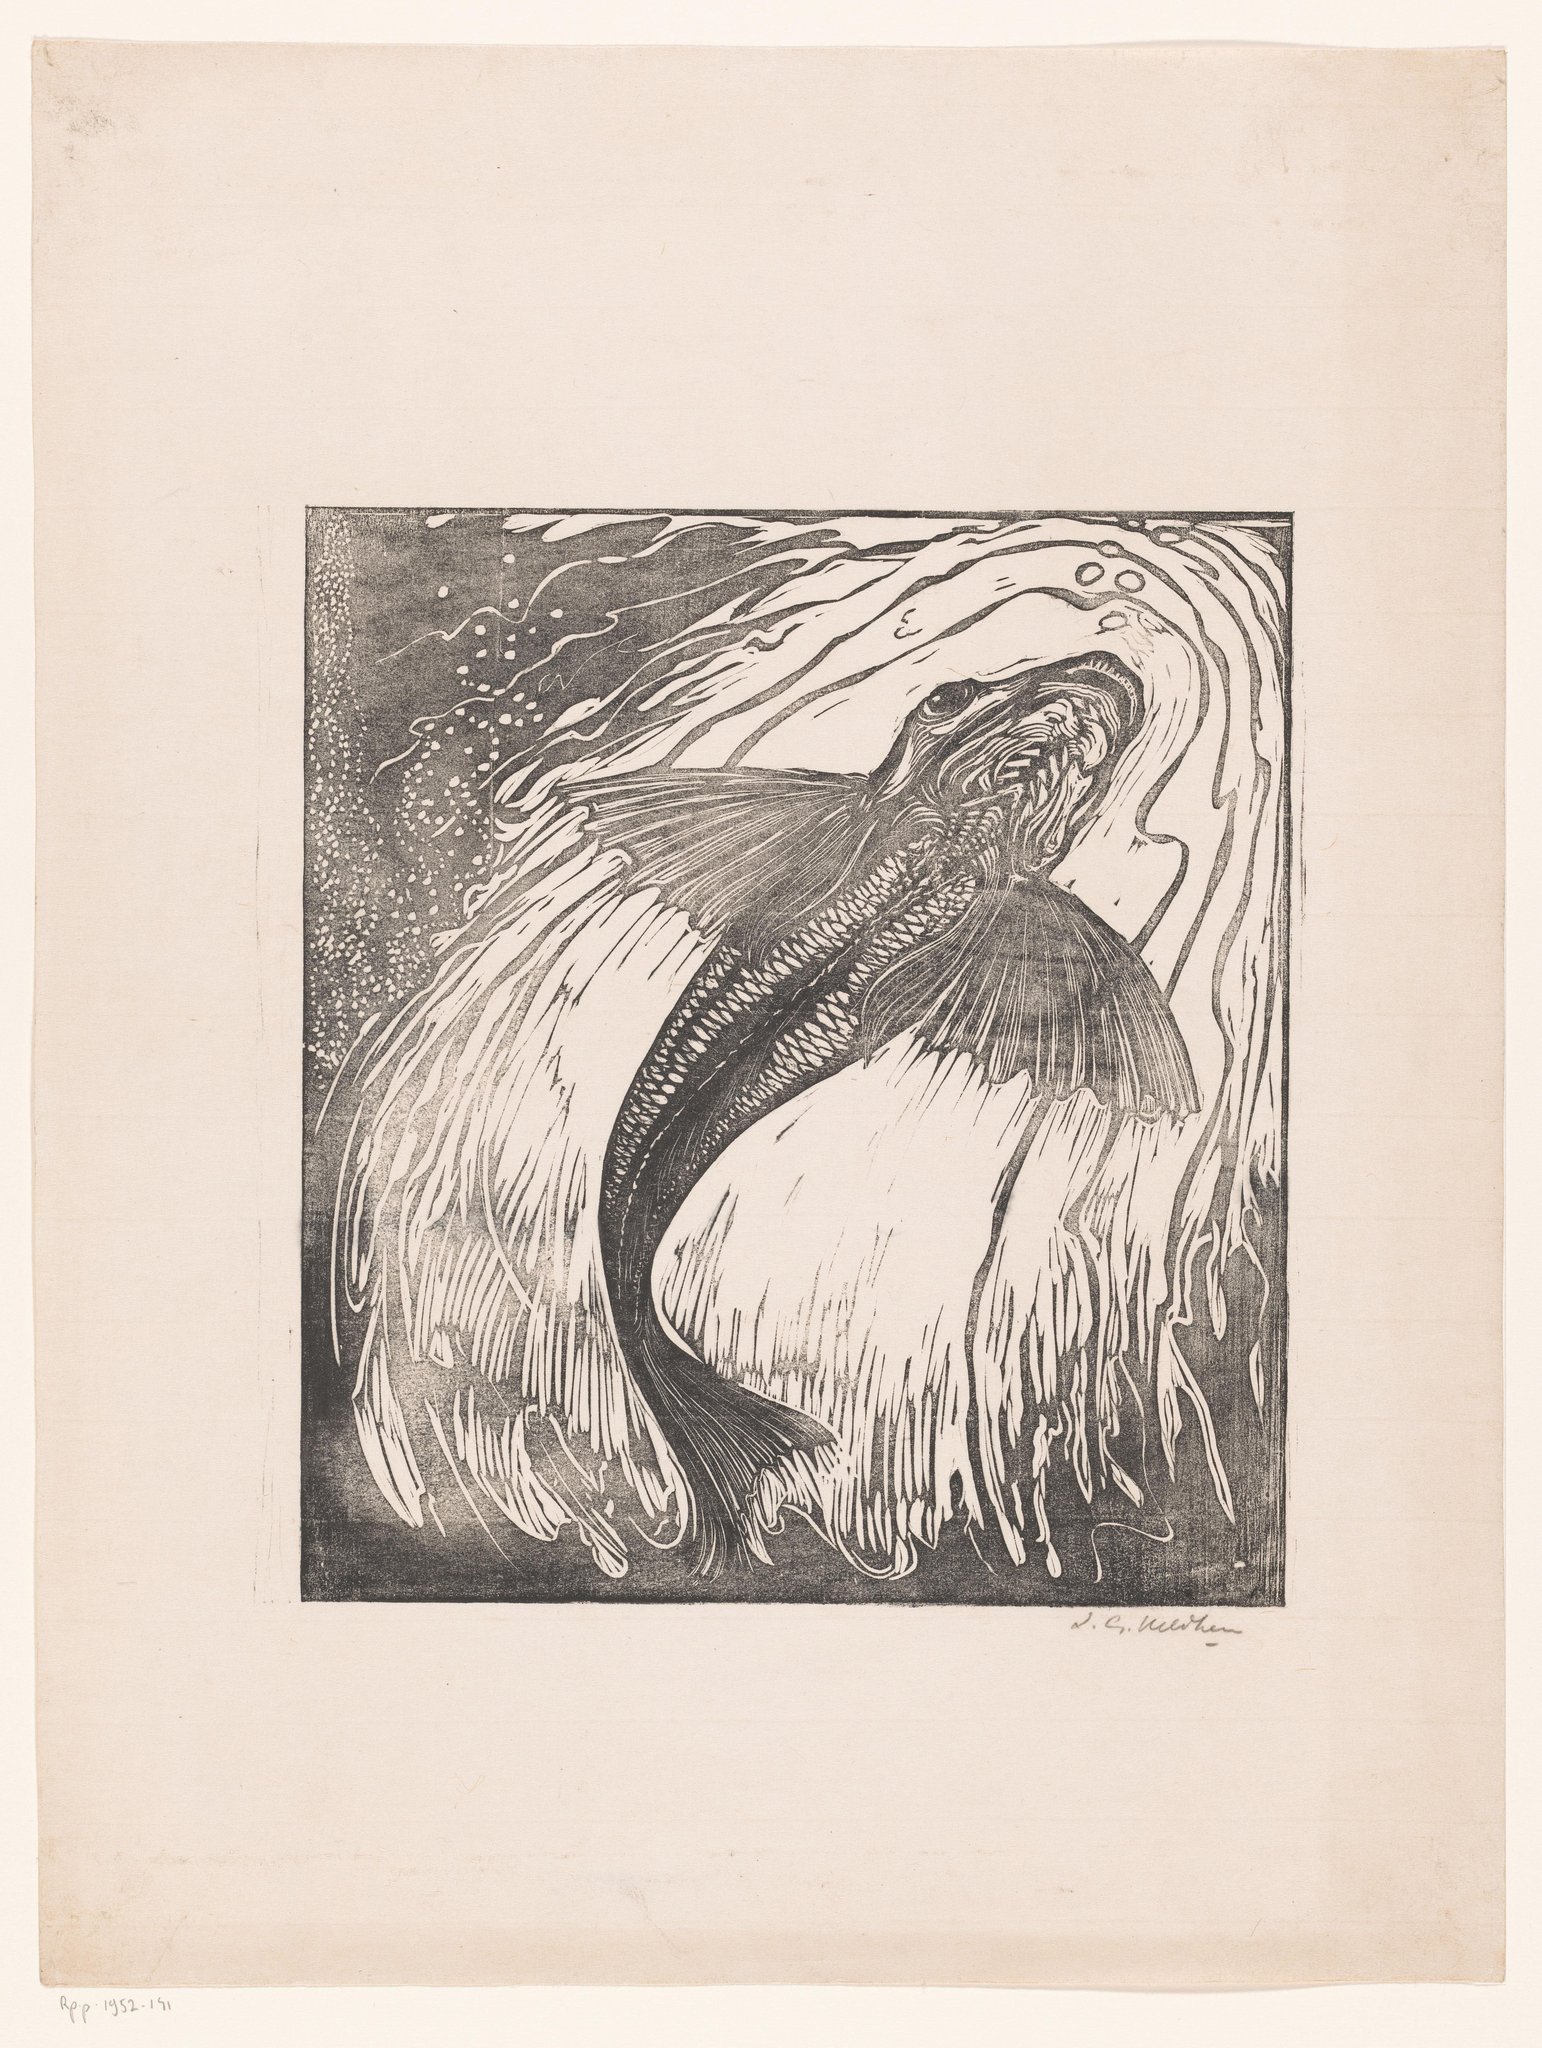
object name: print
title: Vis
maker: jacobus gerardus veldheer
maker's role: draughtsman, print maker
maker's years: 1866-1954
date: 1876-1916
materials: paper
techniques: woodcut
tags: fishes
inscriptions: collector's mark: Lugt 2228